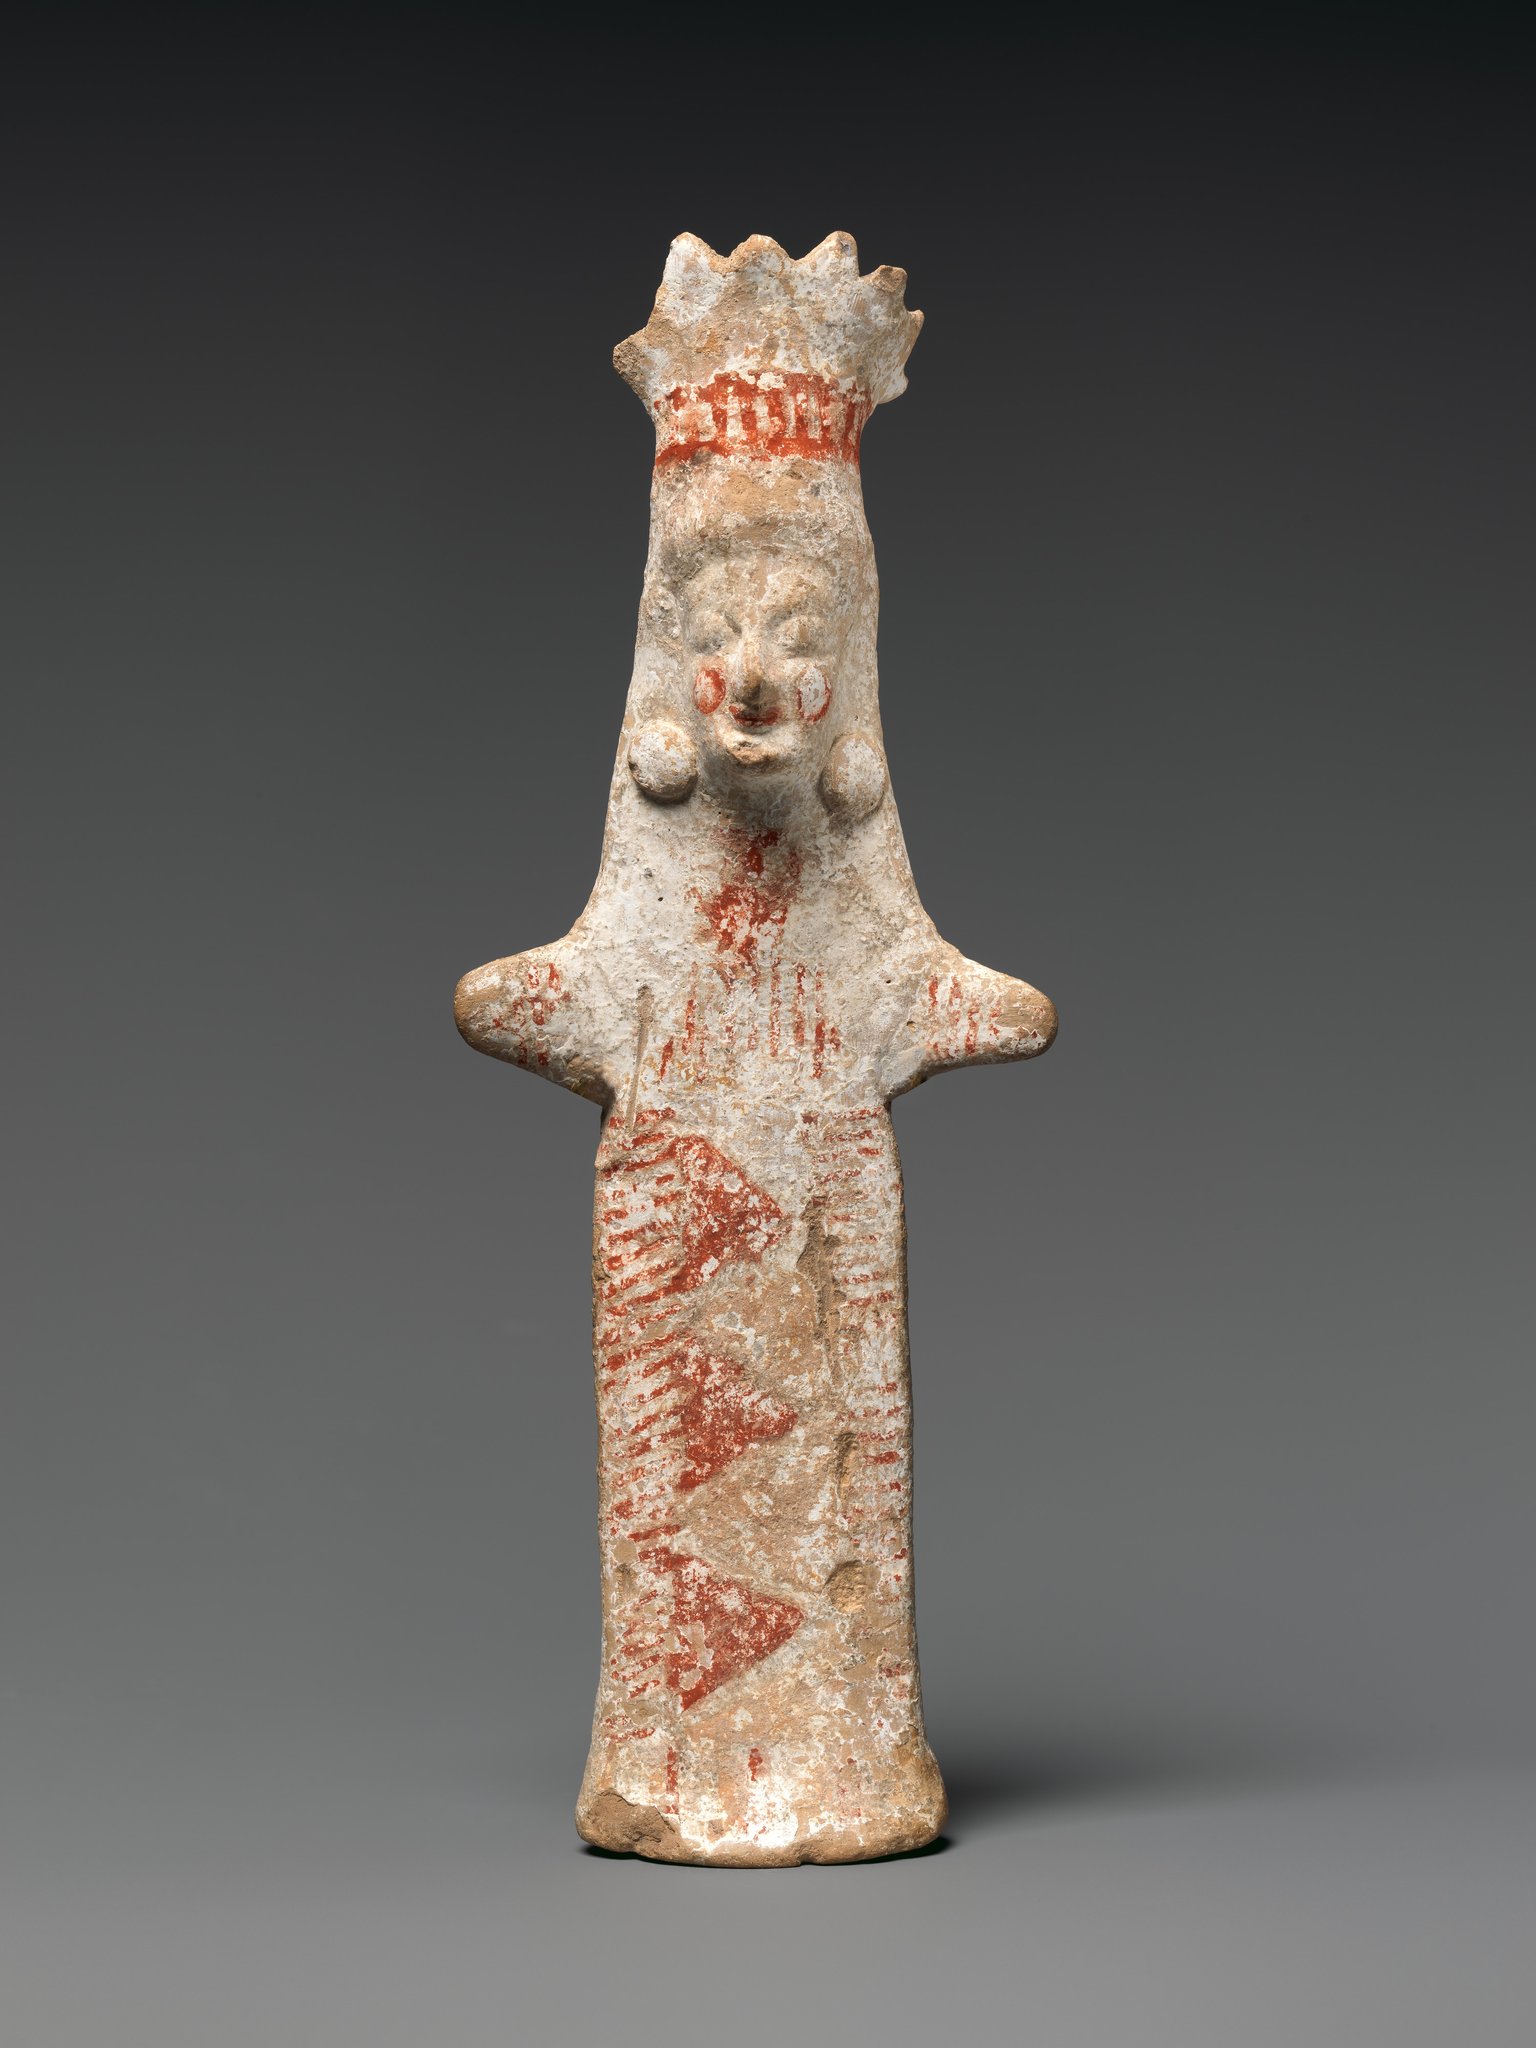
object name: statuette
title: Statuette of a standing goddess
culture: greek, boeotian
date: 525-500 BCE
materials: terracotta